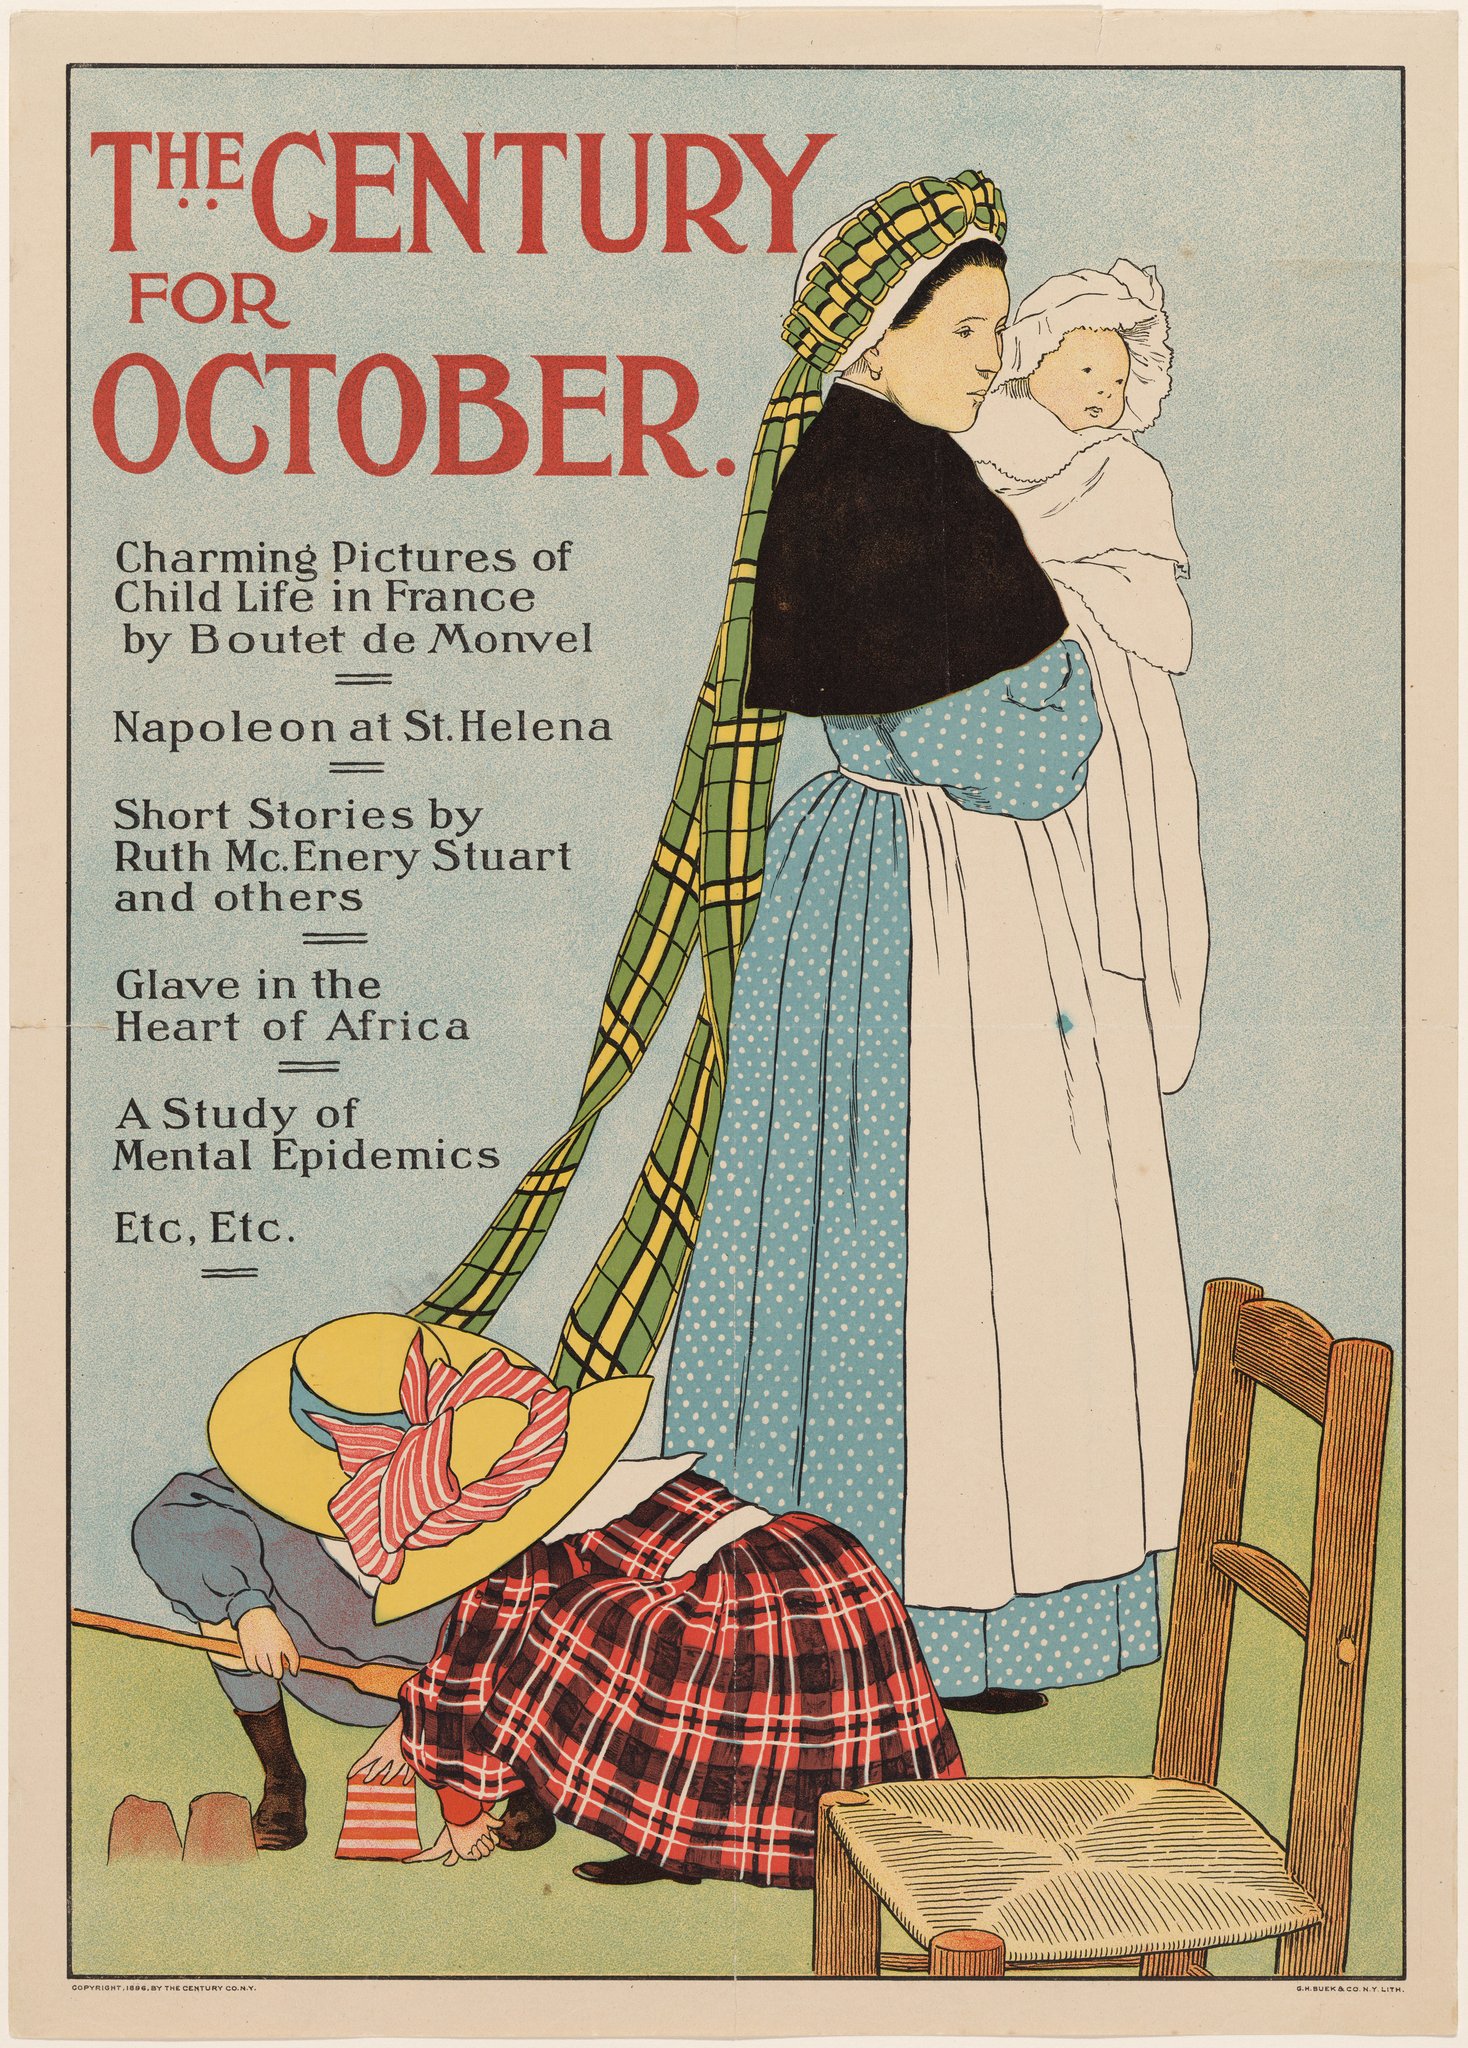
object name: print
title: The Century, October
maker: anonymous, american, 19th century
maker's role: artist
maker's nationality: american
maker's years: 1800-1900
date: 1896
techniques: lithograph